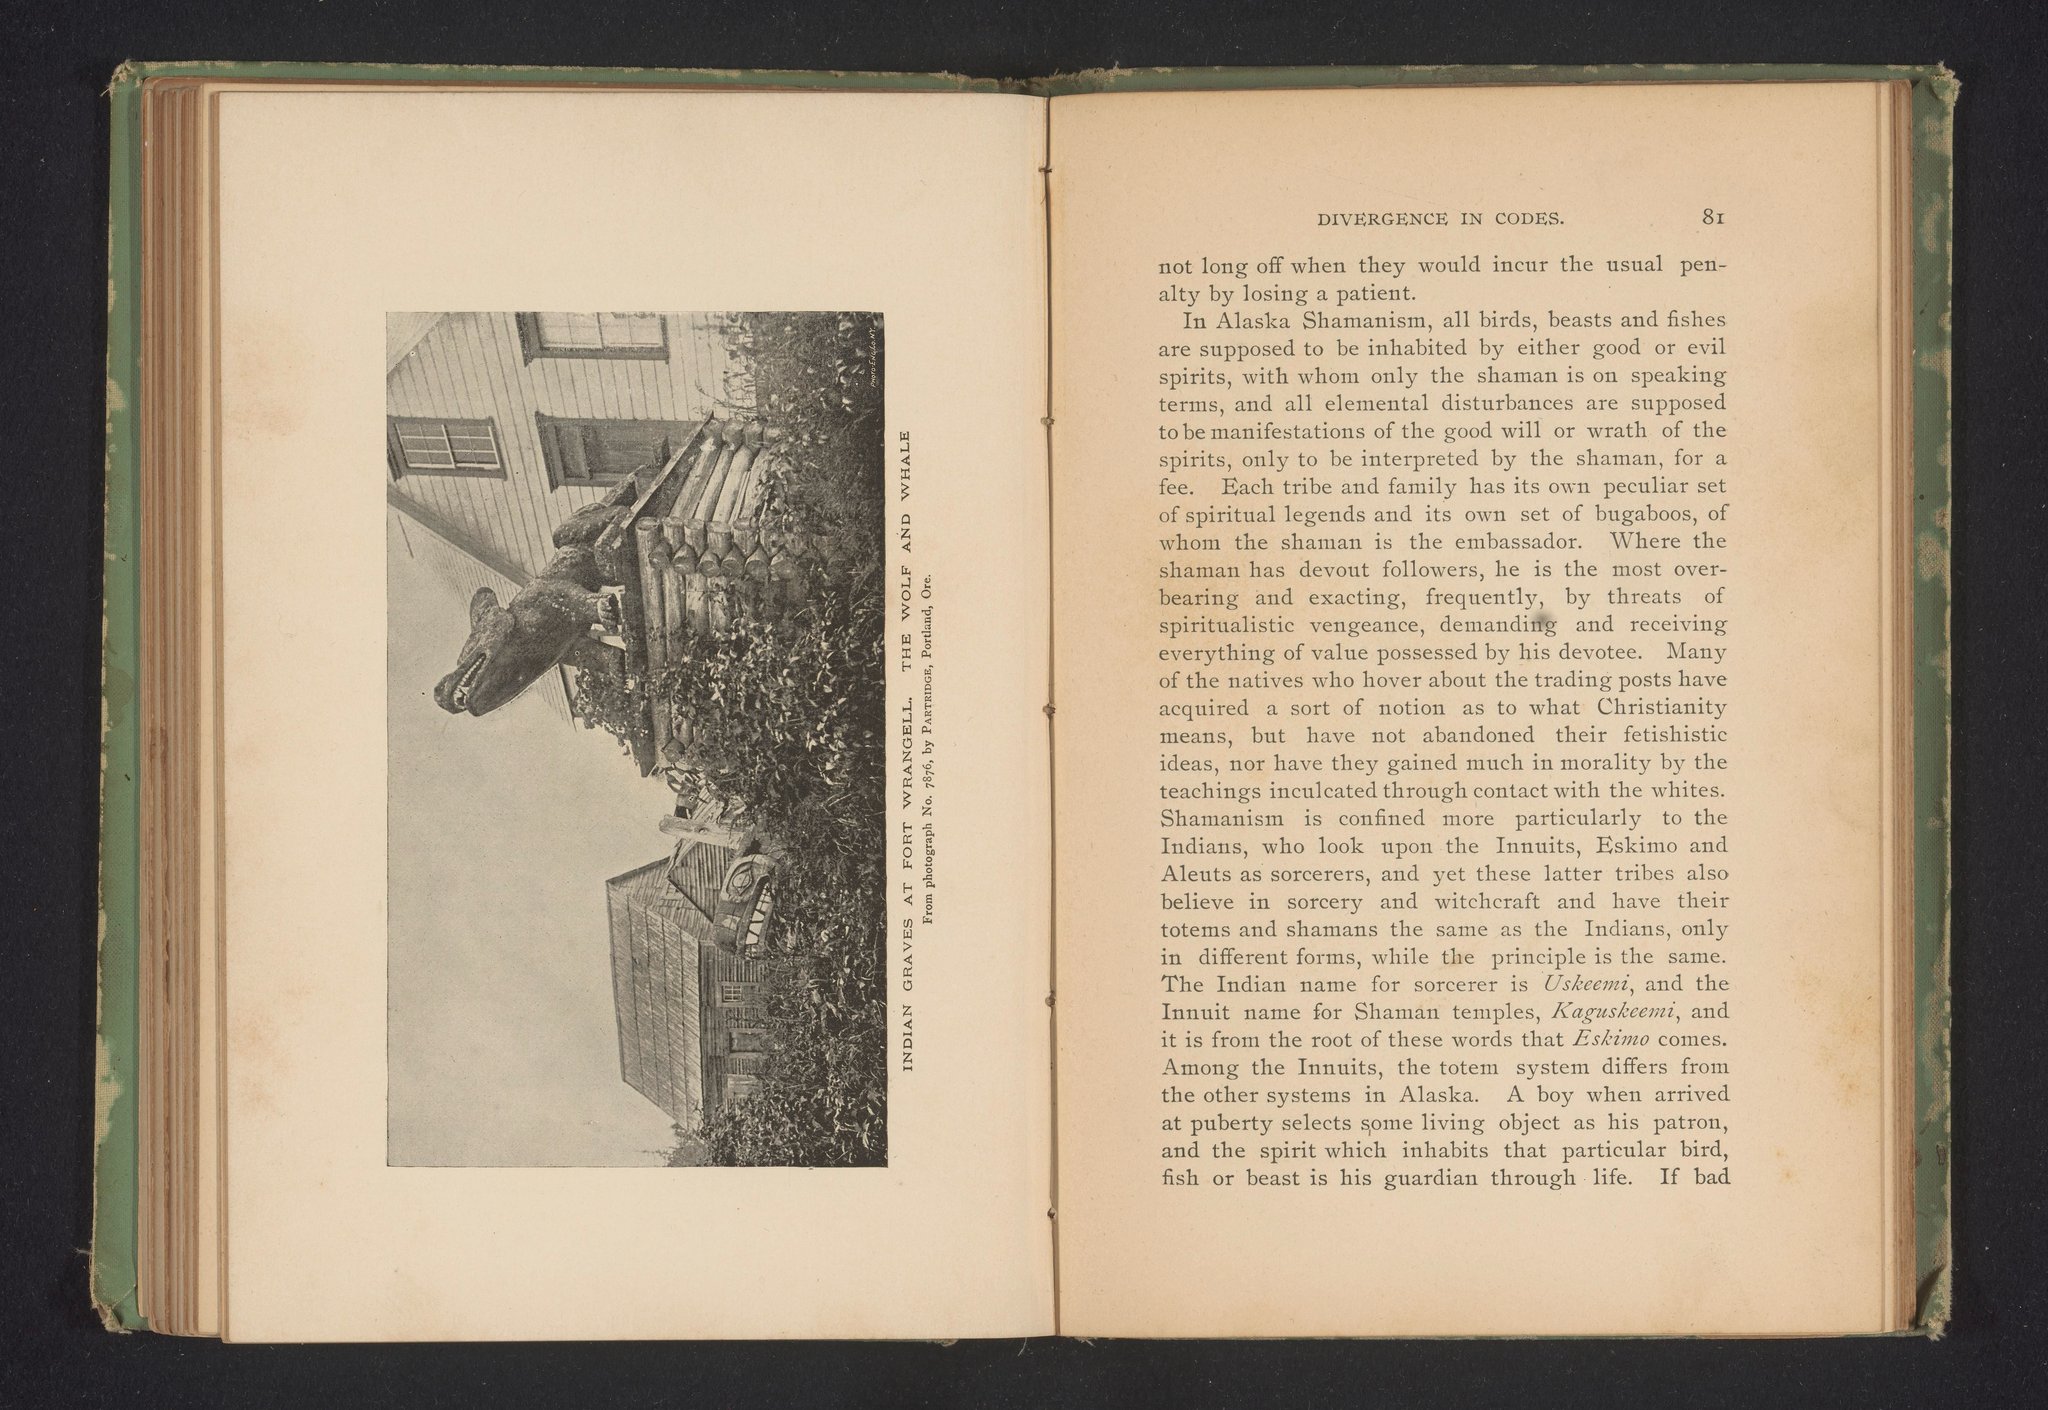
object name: photomechanical print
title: Gezicht op twee indianengraven te Fort Wrangell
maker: william henry partridge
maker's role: fotograaf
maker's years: 1858-1939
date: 1885-1890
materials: paper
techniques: autotype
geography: new york city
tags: indigenous peoples of north america, grave, tomb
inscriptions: inscription: ‘From photograph No. 7876, by Partridge, Portland, Ore.’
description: Gezicht op twee graven van het Tlingitvolk bij Fort Wrangell, Alaska. Bovenop de graven een gesneden beelden van een walvis en een wolf.